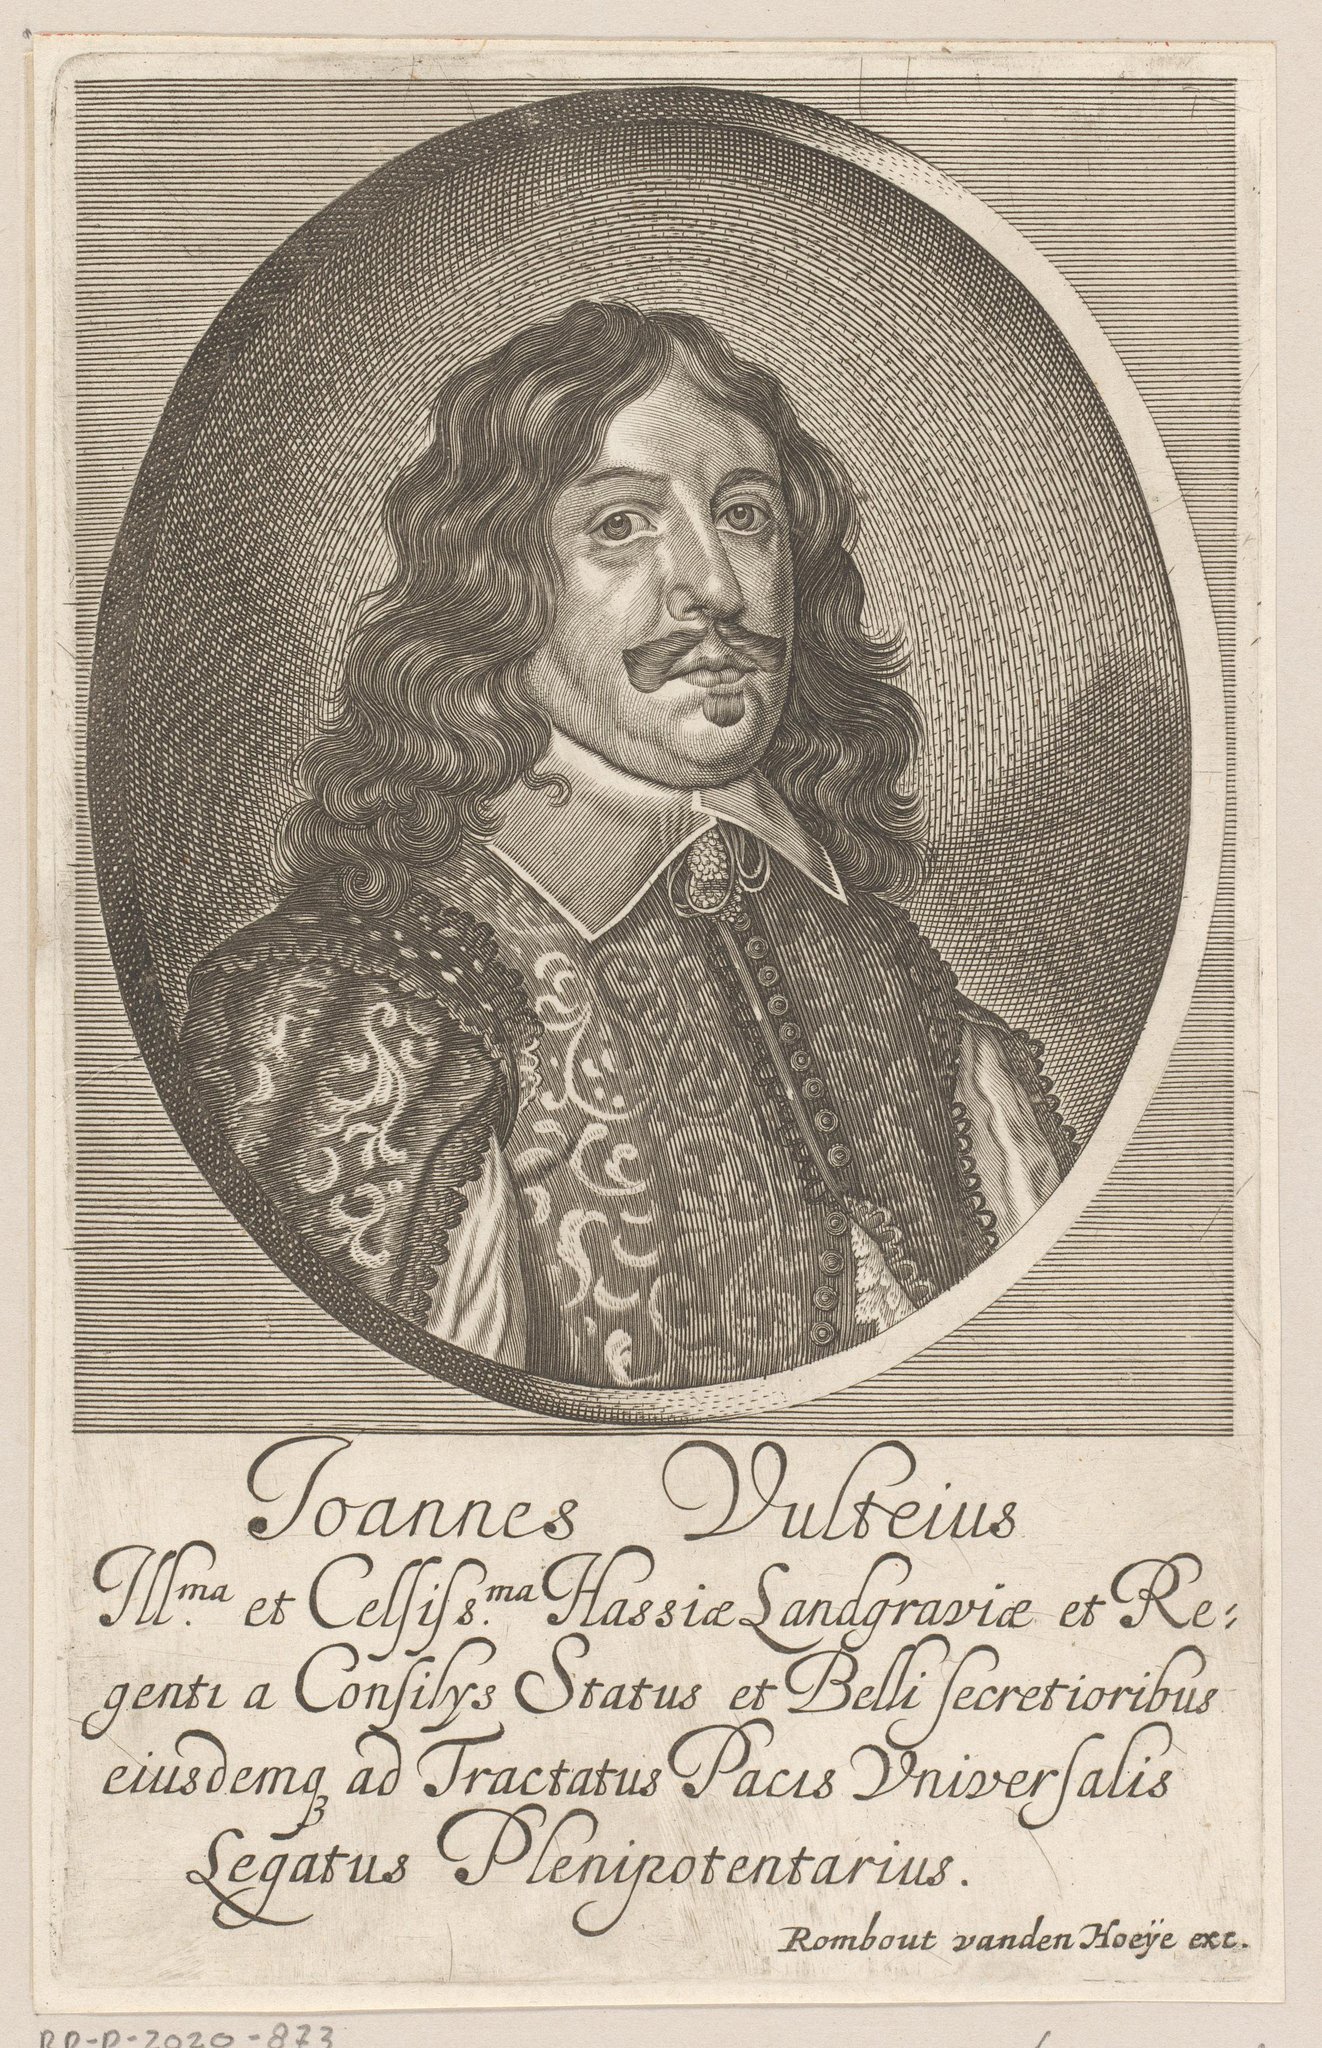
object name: print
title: Pacificatores orbis Christiani in Westphaliam missi anno 1641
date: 1644-1671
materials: paper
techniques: engraving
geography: amsterdam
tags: official; civil servant; functionary (in general), historical persons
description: Prent maakt deel uit van een serie van 43 prenten. Eerdere staat van prent gebruikt in de serie 'Icones legatorum Monasterii et Osnabrugae existentium', uitgegeven door Abraham van Waesbergen in Amsterdam.